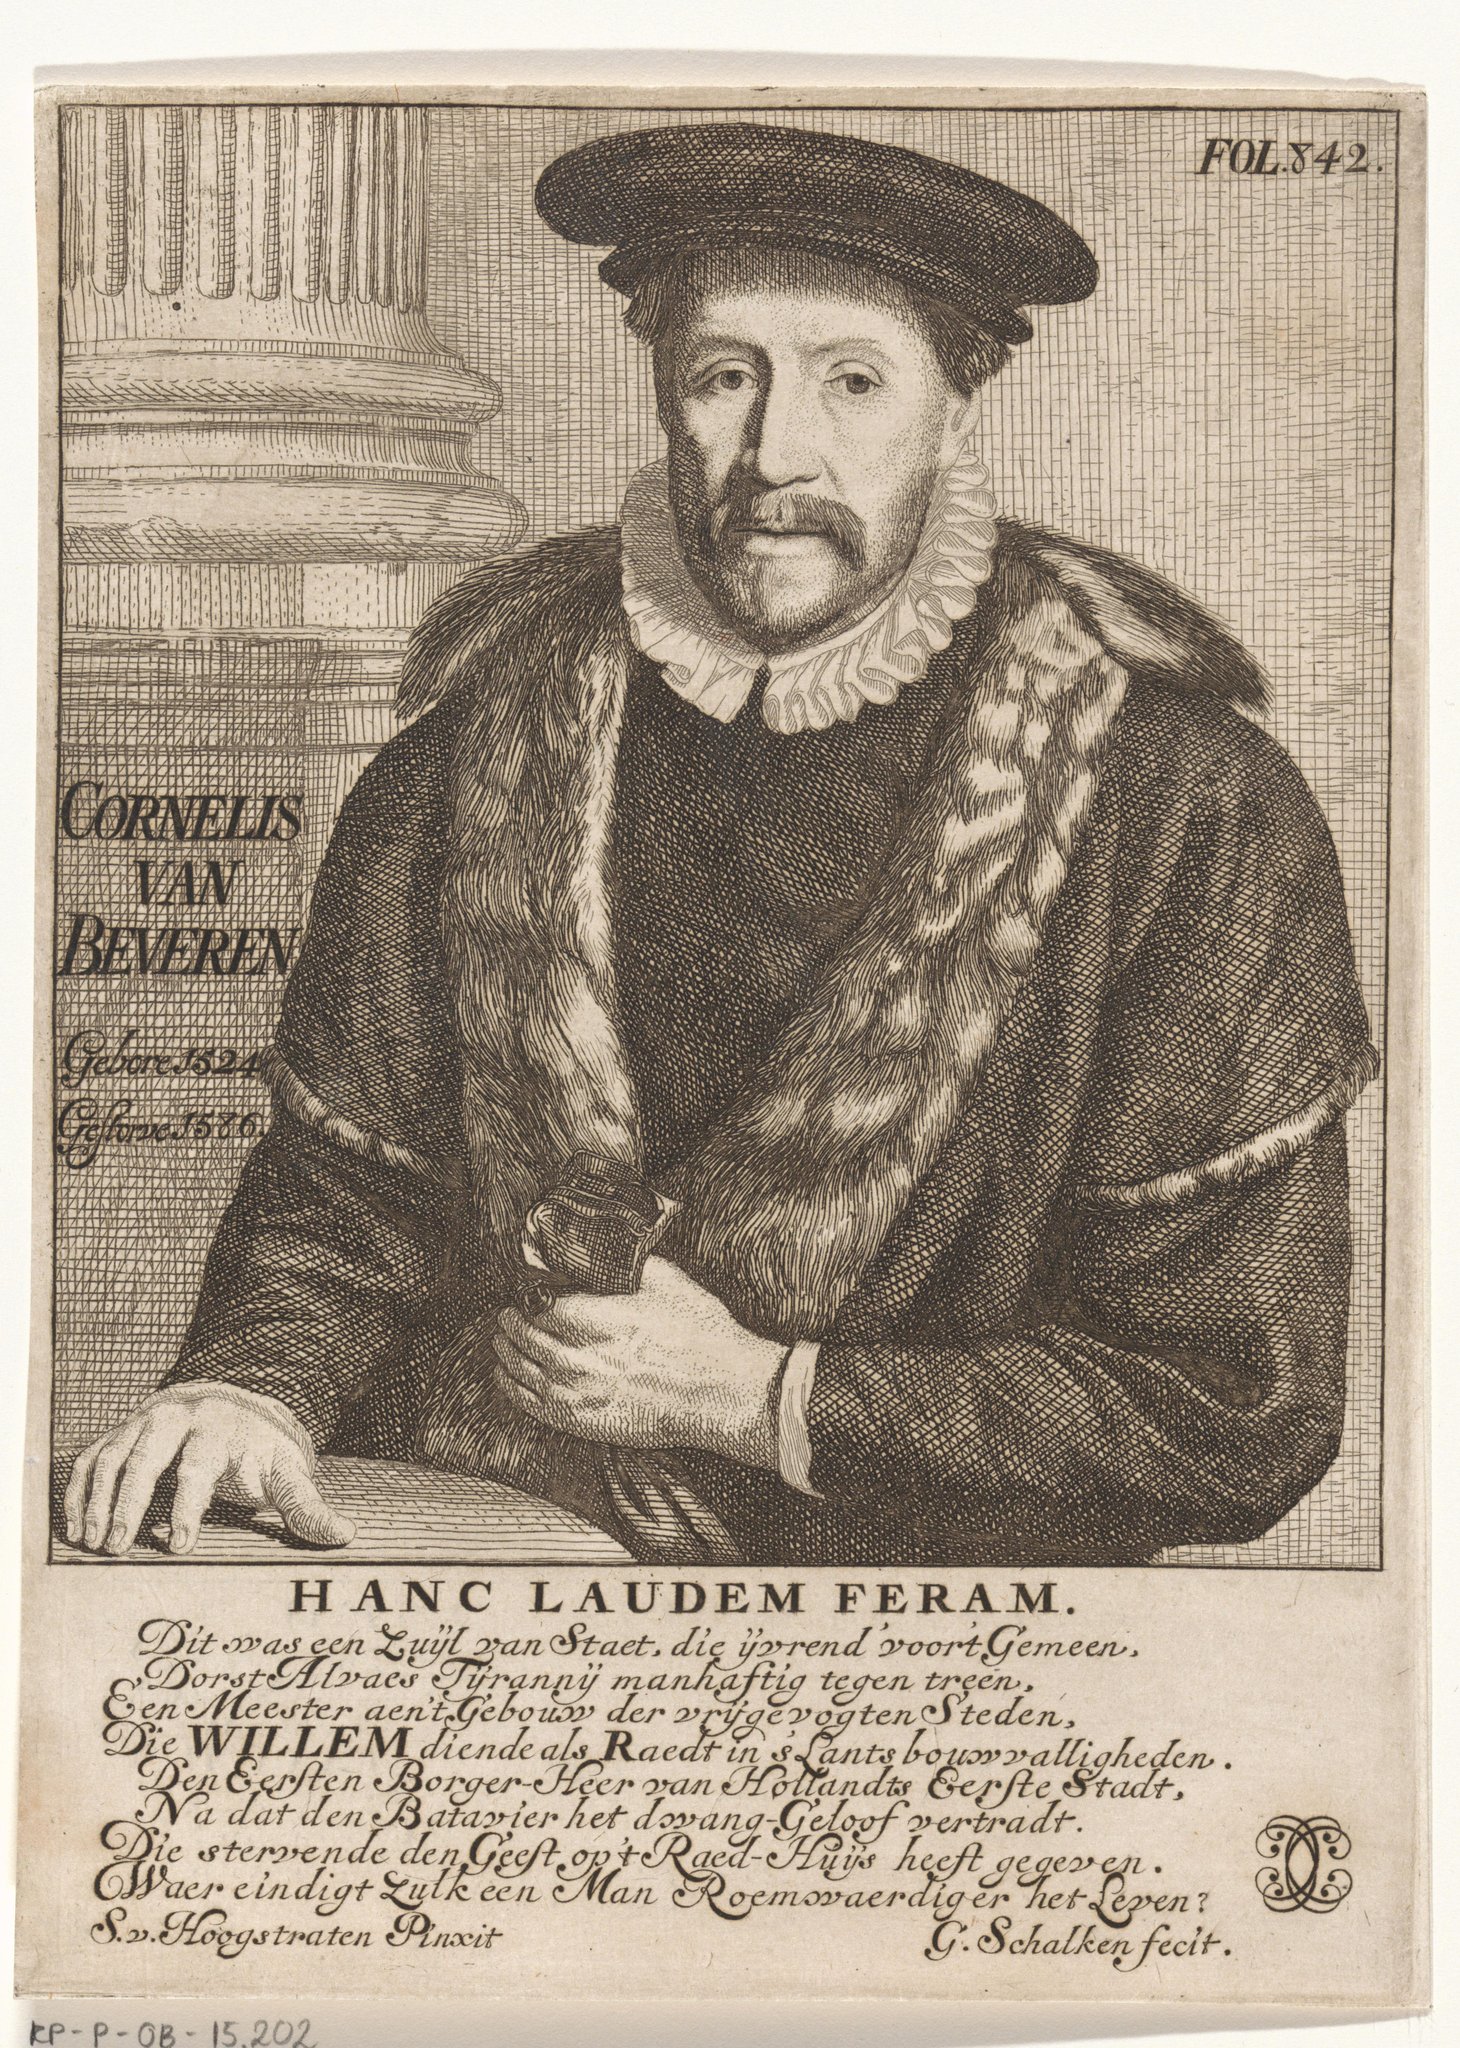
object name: print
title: Portret van Cornelis van Beveren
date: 1677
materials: paper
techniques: etching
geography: dordrecht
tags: historical persons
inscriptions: collector's mark: Lugt 2228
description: Portret van de Dordtse burgemeester Cornelis van Beveren. Hij draagt een met bont afgezette mantel, een plooikraag en een baret. In zijn linkerhand draagt hij een paar handschoenen(?). Links achter hem staat een zuil. Op de sokkel onder de zuil staat de naam van Van Beveren met zijn geboorte- en sterfjaar. Onder de voorstelling een éénregelige Latijnse uitspraak en daaronder een achtregelig, Nederlands lofdicht over de geportretteerde. Rechtsboven: Fol. 842.